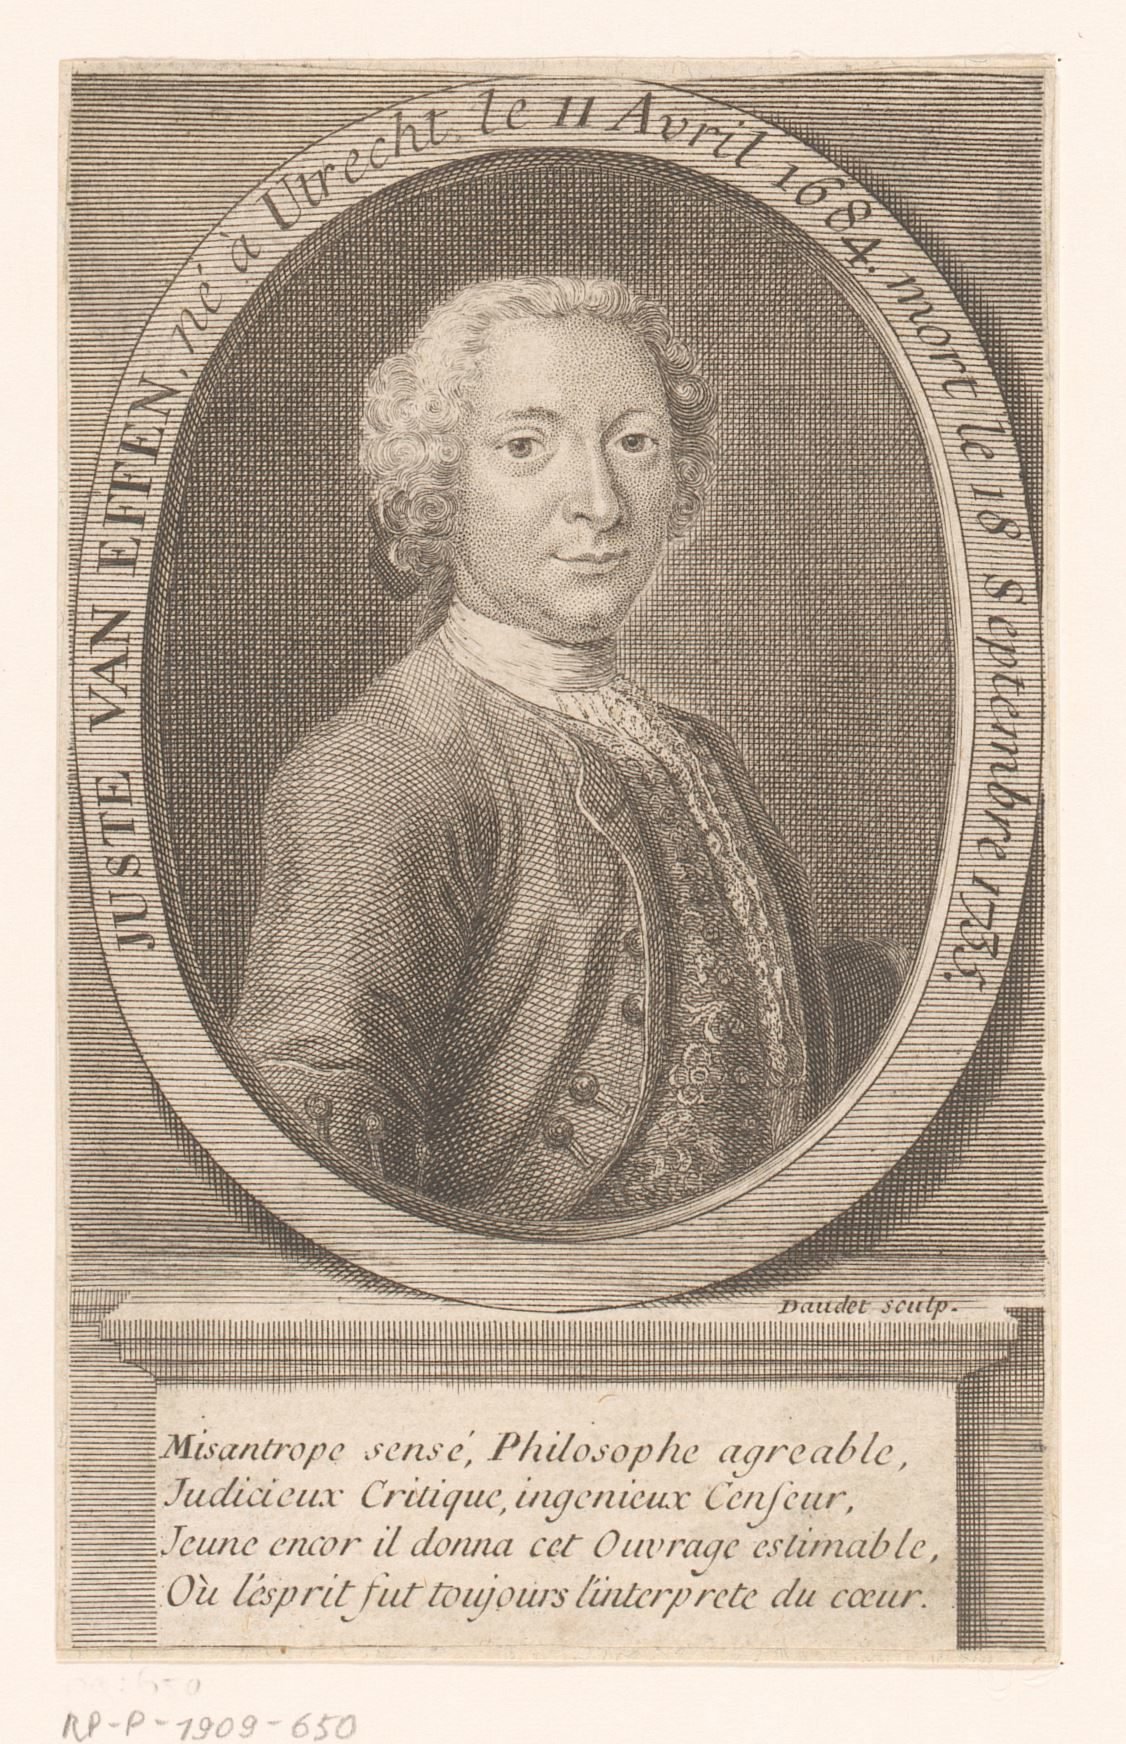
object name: print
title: Juste Van Effen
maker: robert daudet (i)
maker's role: print maker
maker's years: 1647-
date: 1735-1800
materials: paper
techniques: engraving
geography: lyon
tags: utrecht, den bosch, ornament ~ medallion, historical persons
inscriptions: collector's mark: Lugt 2228